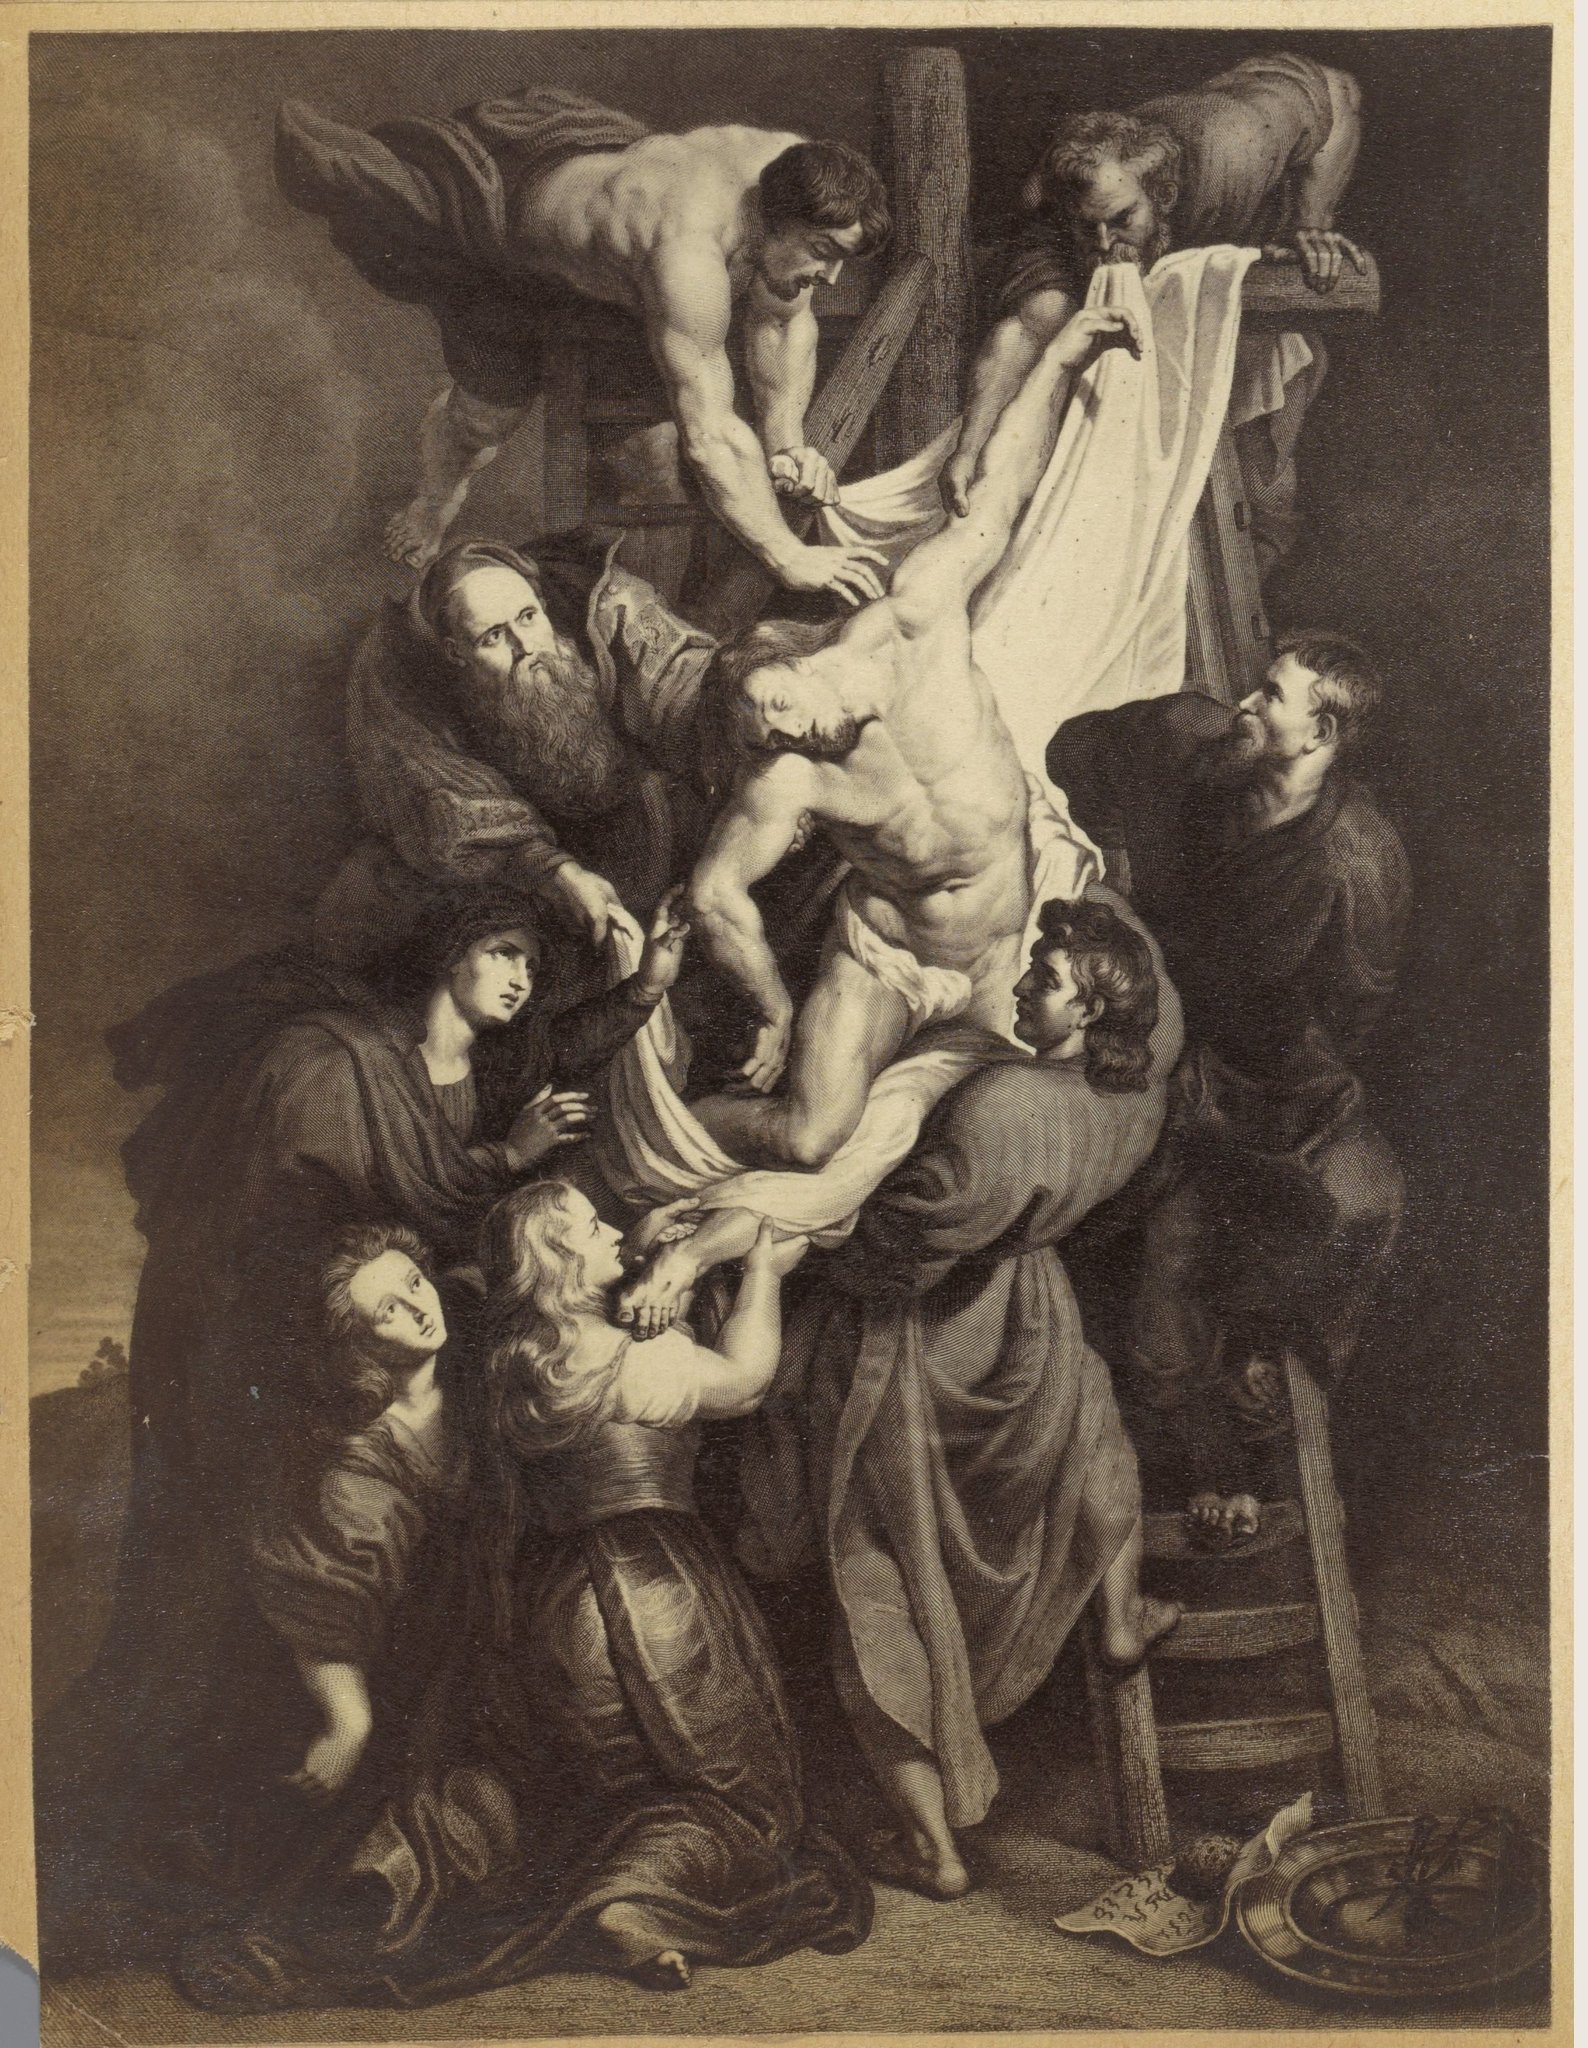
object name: photograph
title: Fotoreproductie van een prent naar het schilderij Kruisafneming door Peter Paul Rubens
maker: Anonymous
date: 1851-1900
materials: cardboard, paper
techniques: albumen print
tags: descent from the cross: christ is taken down from the cross, usually by nicodemus and joseph of arimathaea who are standing on the ladders (both arms of christ detached)